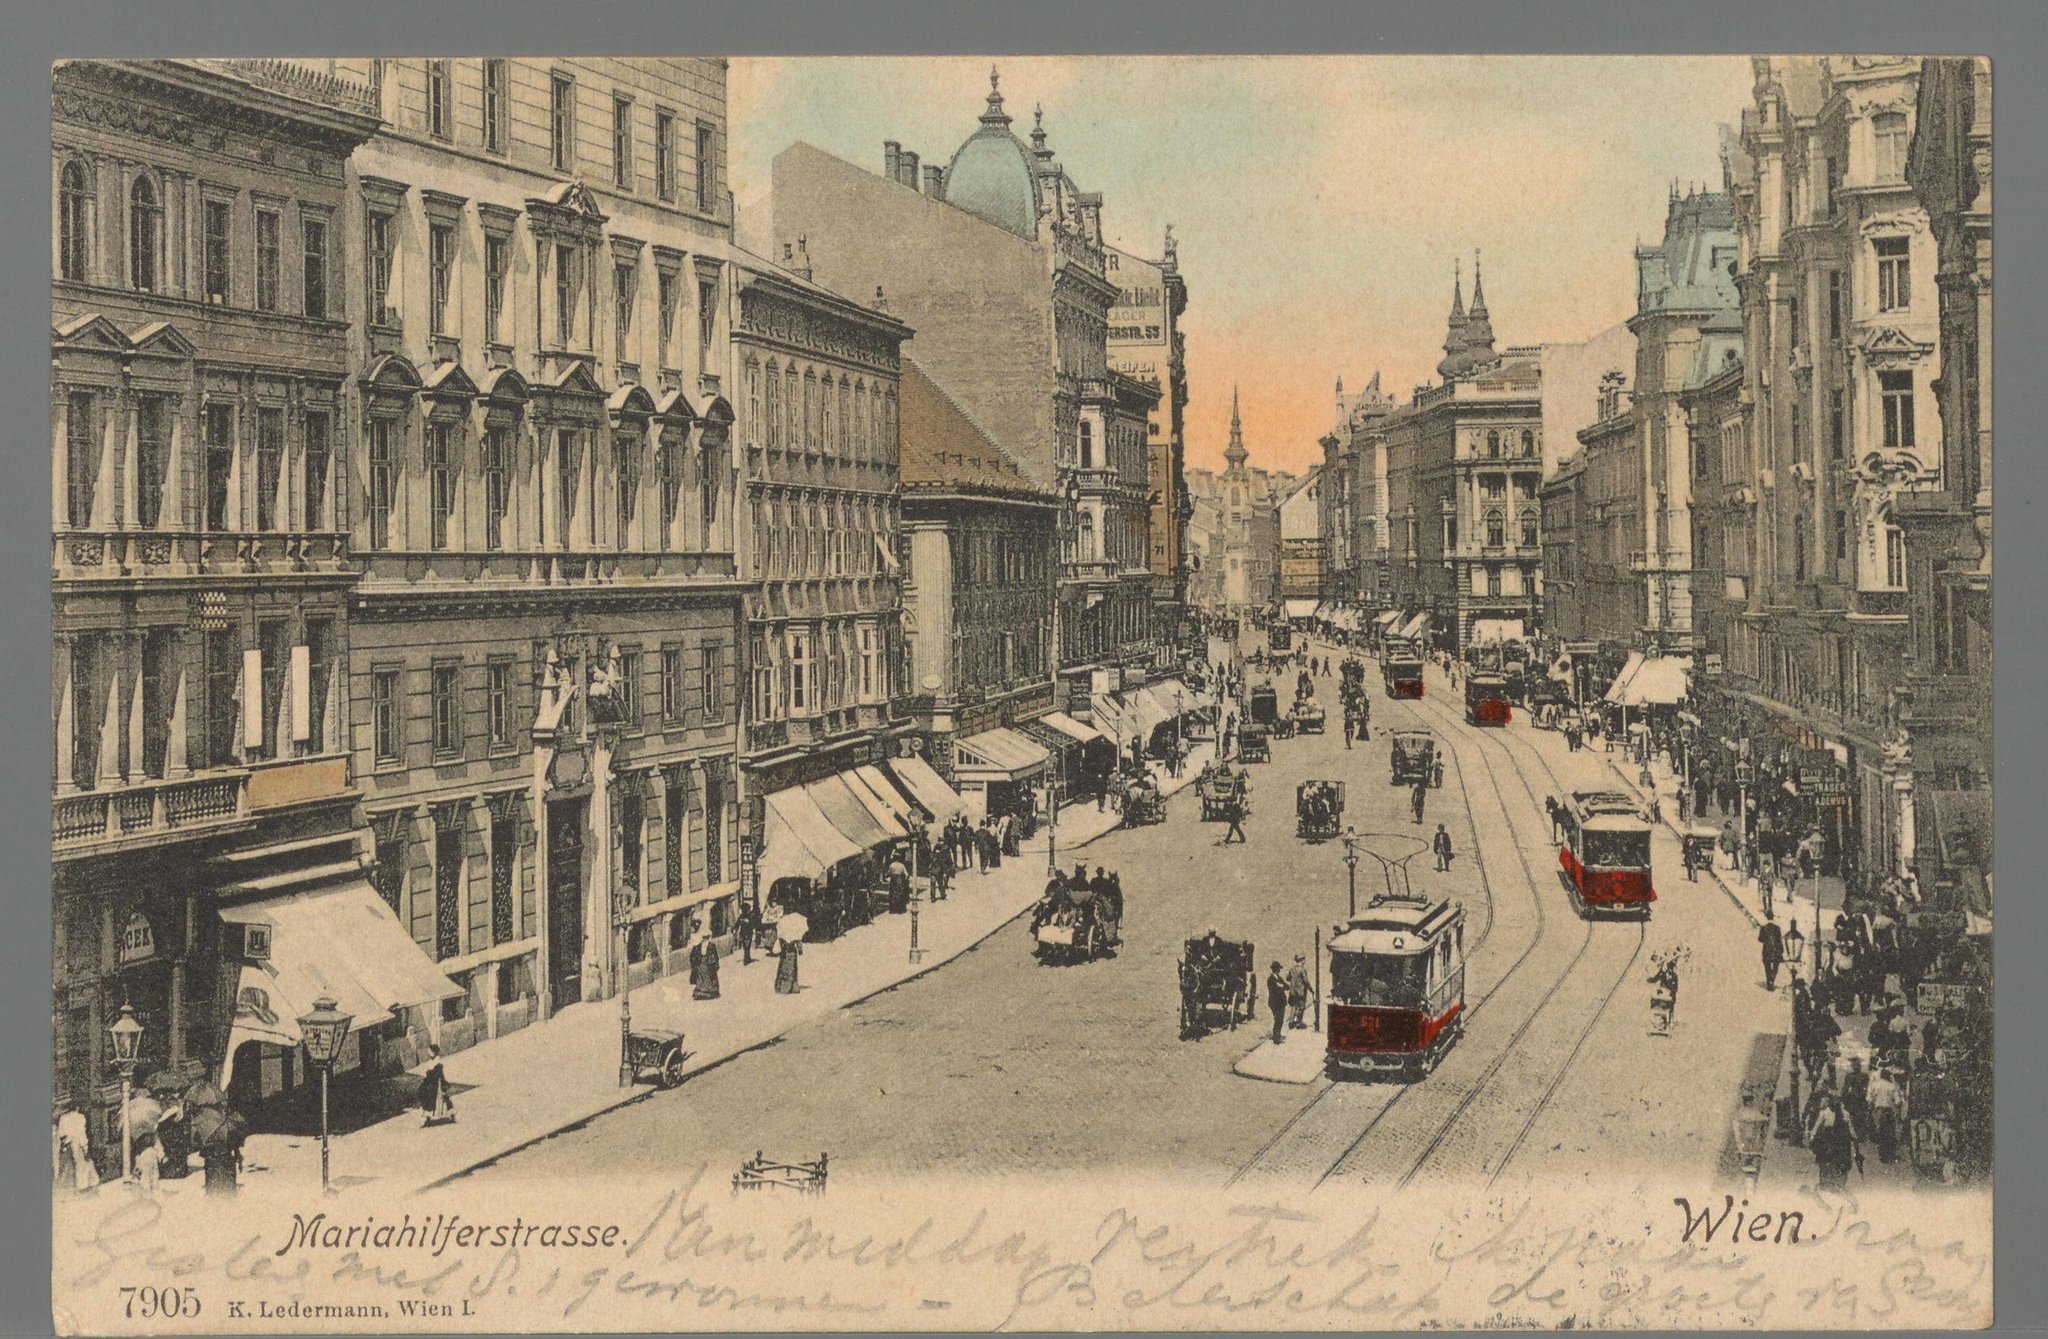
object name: ansichtkaart, prentbriefkaart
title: Mariahilferstrasse. Wien.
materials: cardboard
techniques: photograph, lithograph, writing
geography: vienna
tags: street, vienna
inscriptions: postage stamp